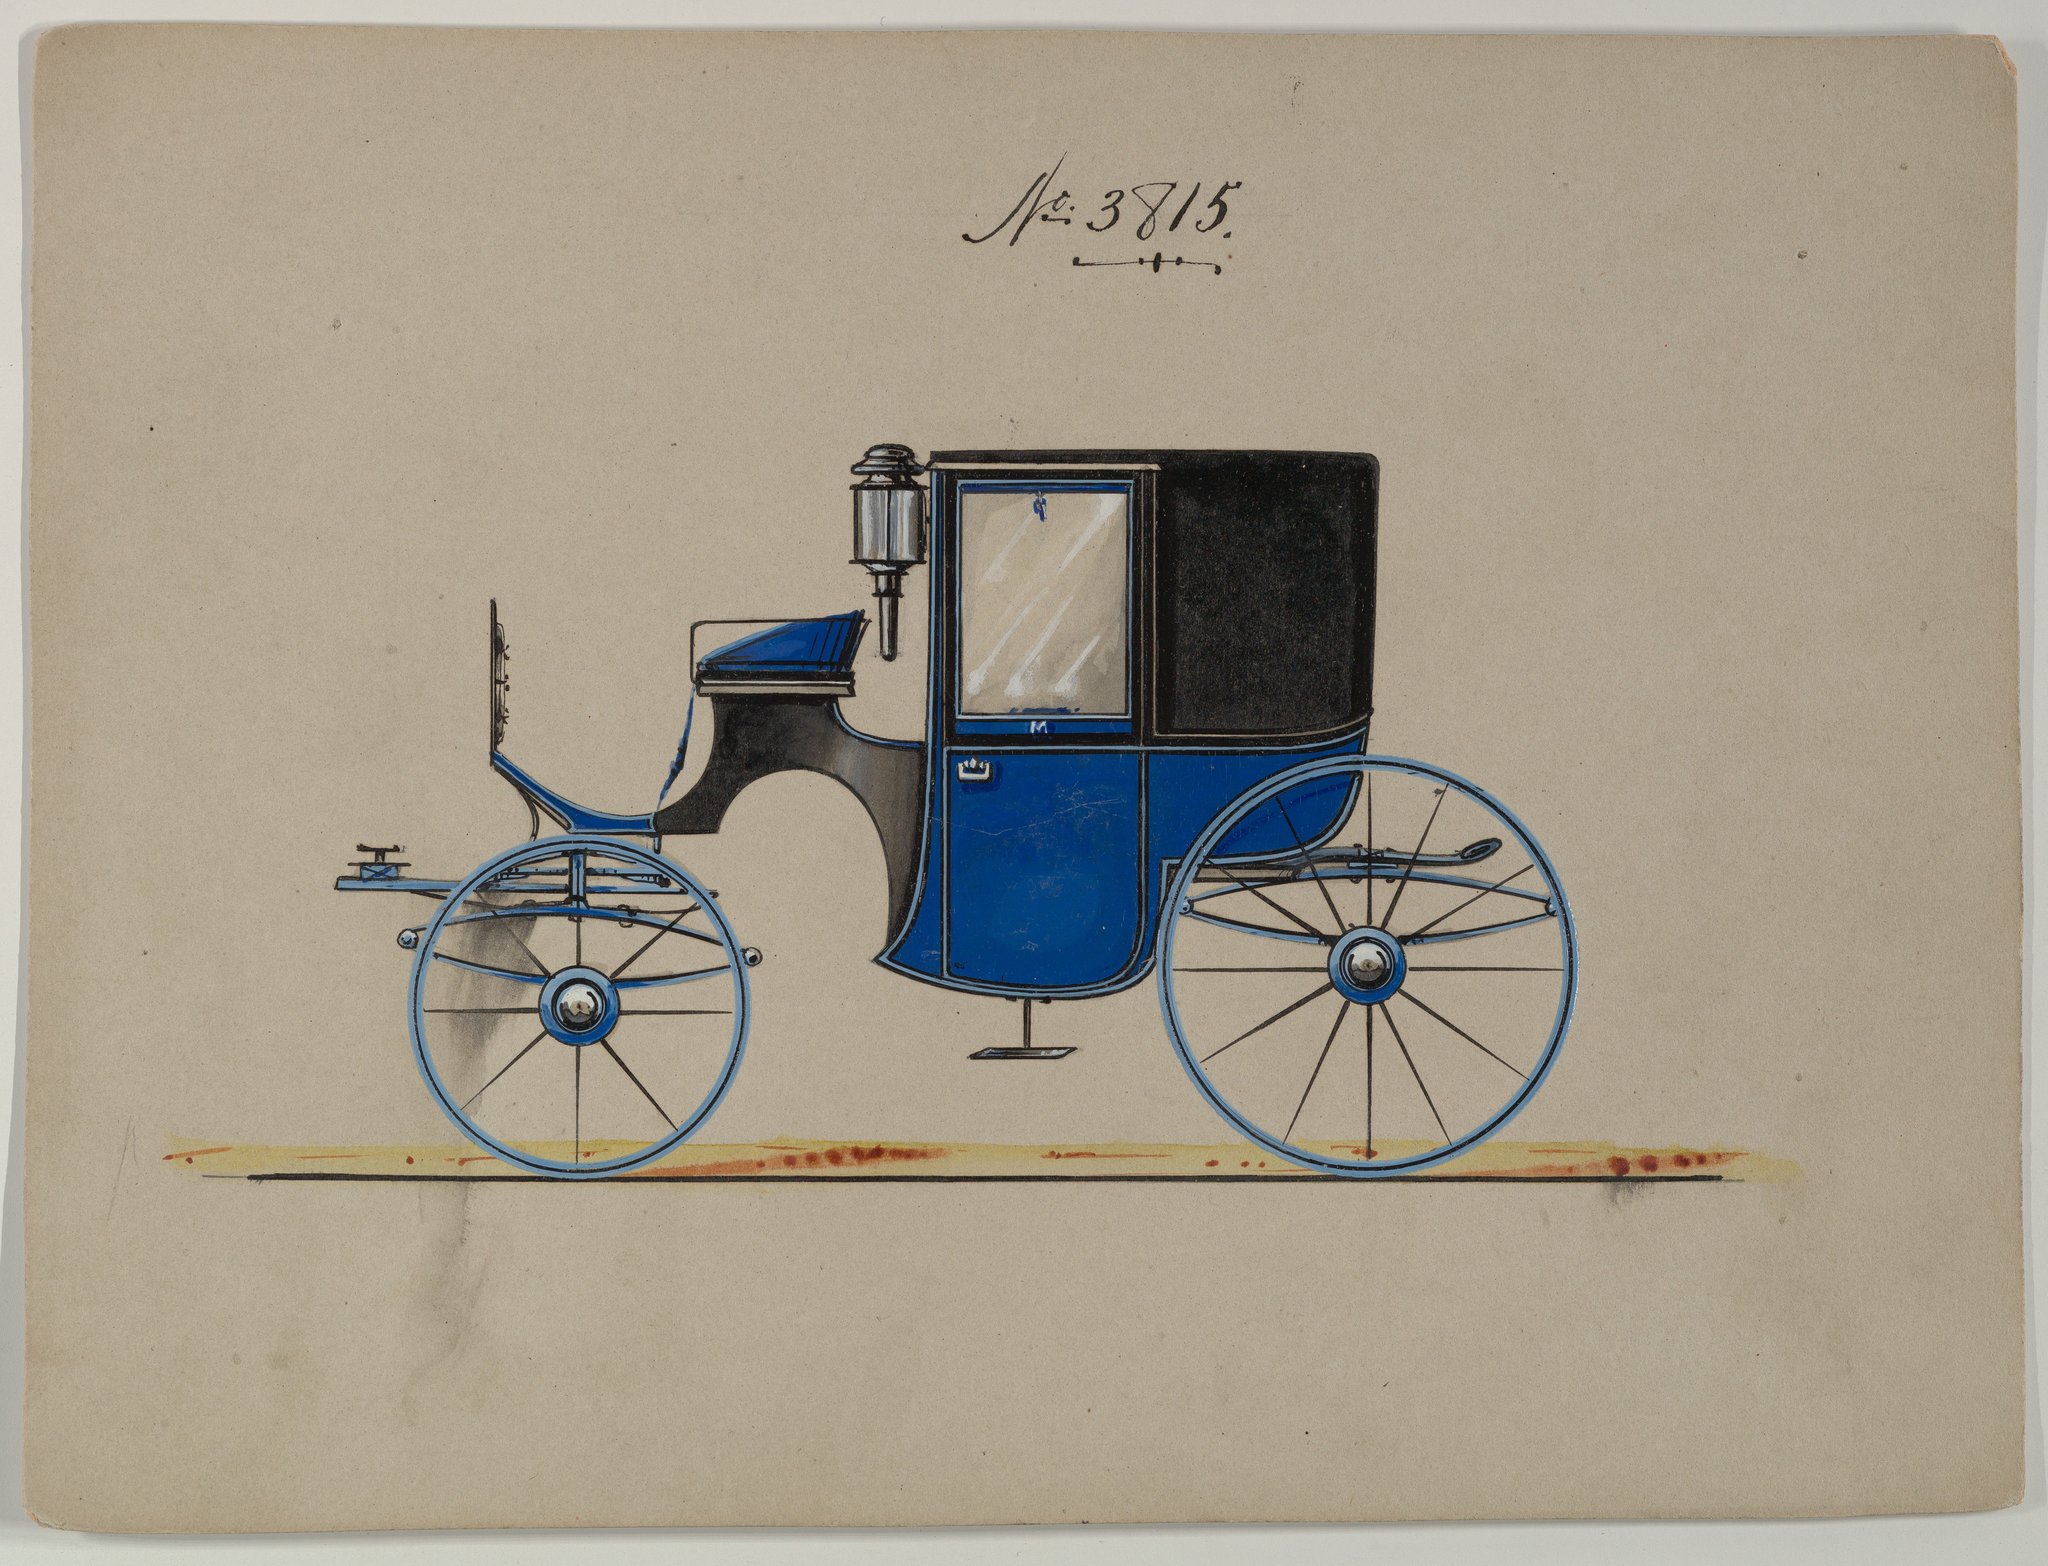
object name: drawing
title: Brougham #3815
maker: brewster & co.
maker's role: manufacturer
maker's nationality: american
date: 1883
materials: gouache, gum arabic, ink, watercolor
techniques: pen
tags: carriages